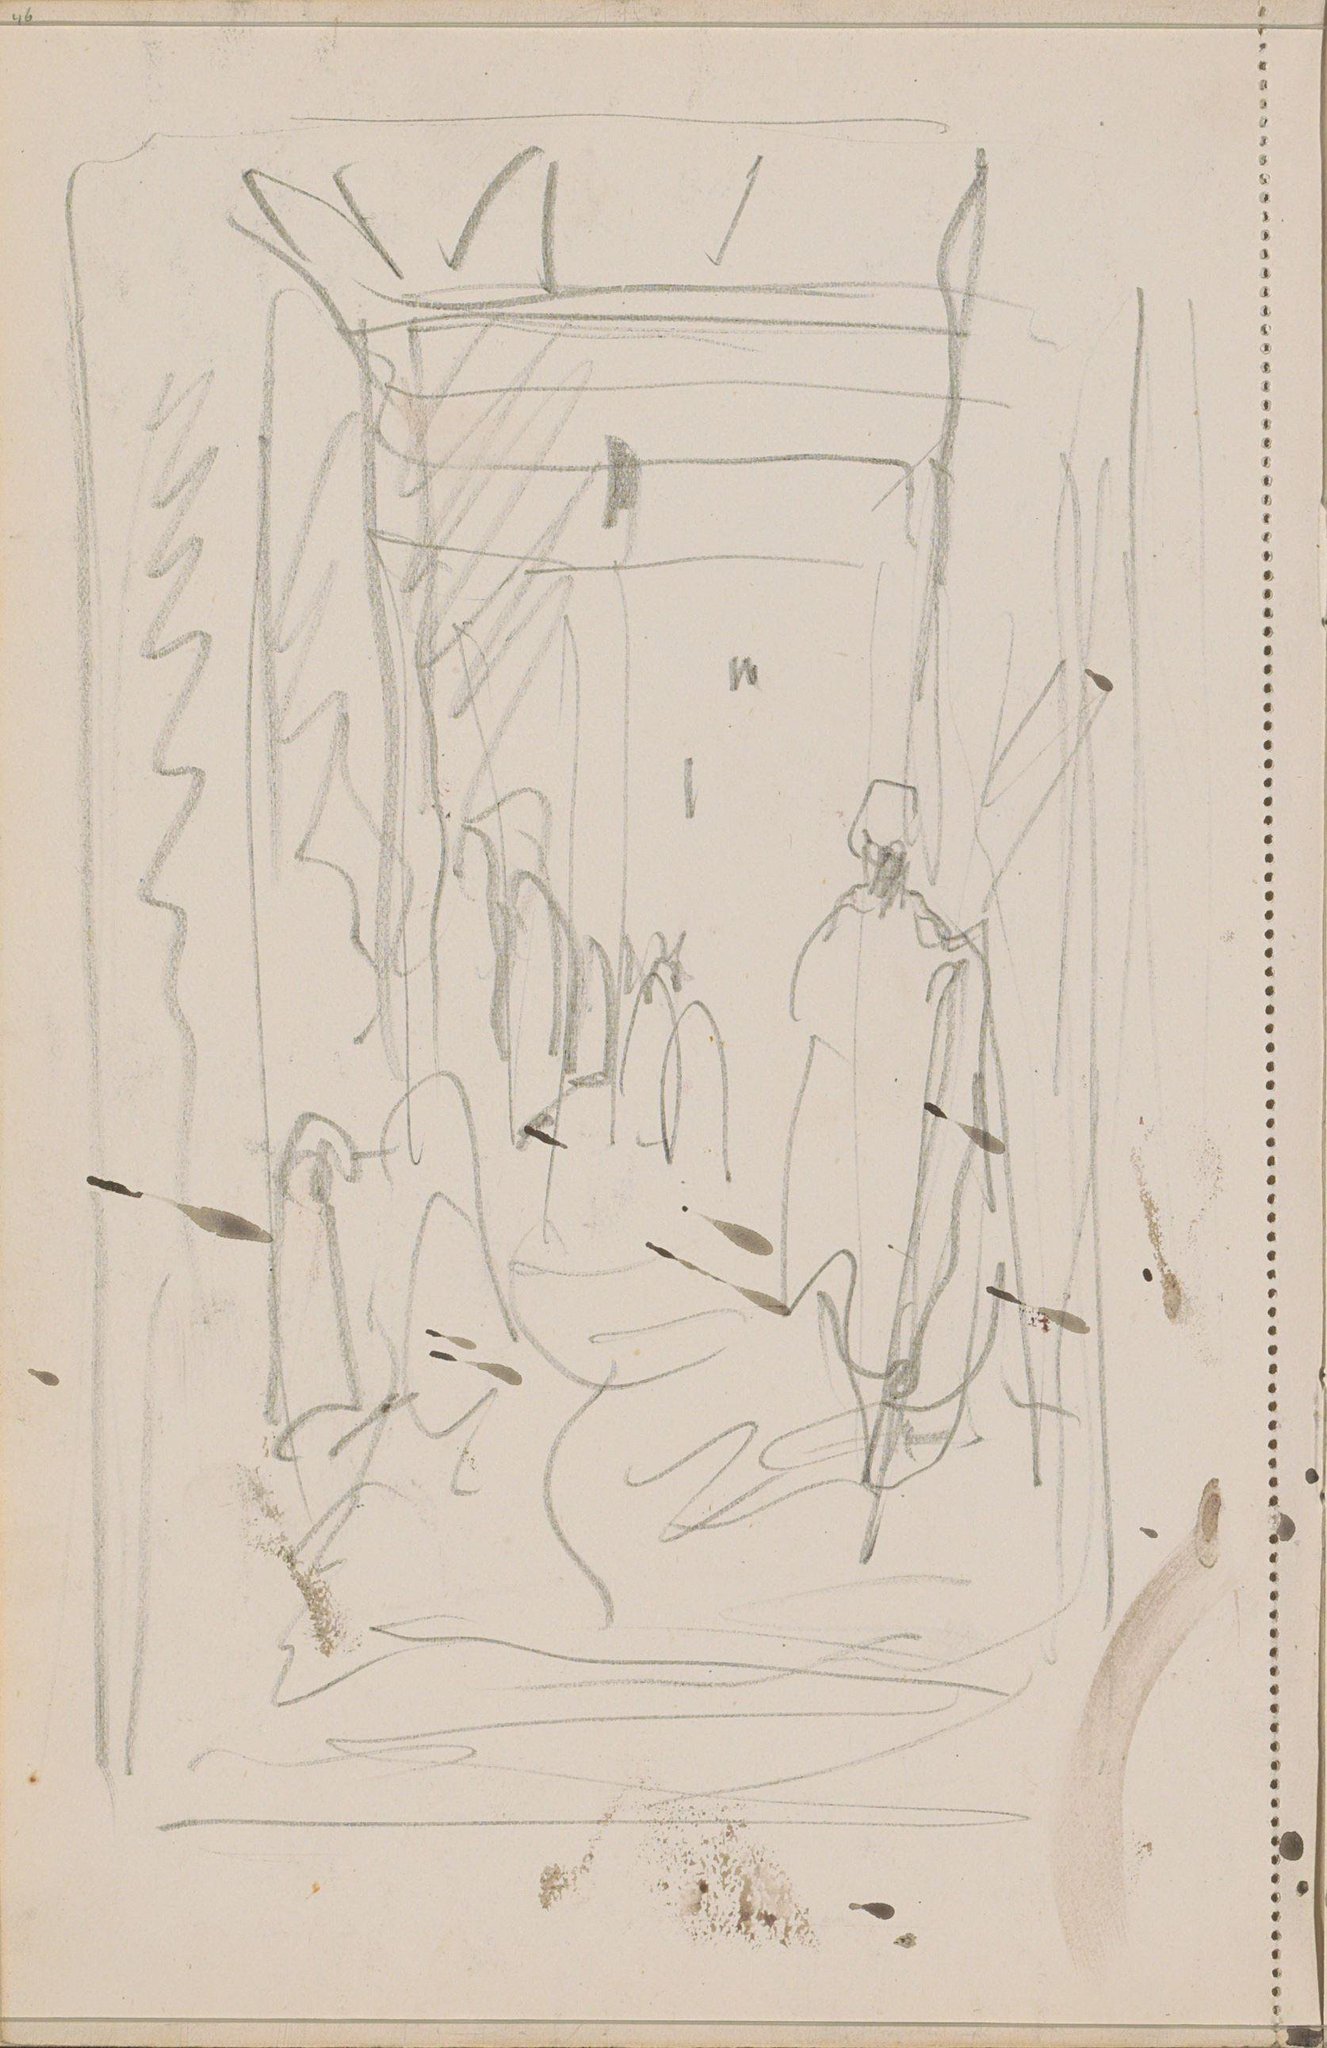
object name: sketchbook leaf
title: Figuren in een interieur, vermoedelijk een gang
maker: marius bauer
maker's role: draughtsman, print maker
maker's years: 1867-1932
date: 1923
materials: paper, pencil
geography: morocco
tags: corridor, africans, interior ~ representation of a building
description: Pagina 46 uit een schetsboek met 66 bladen.